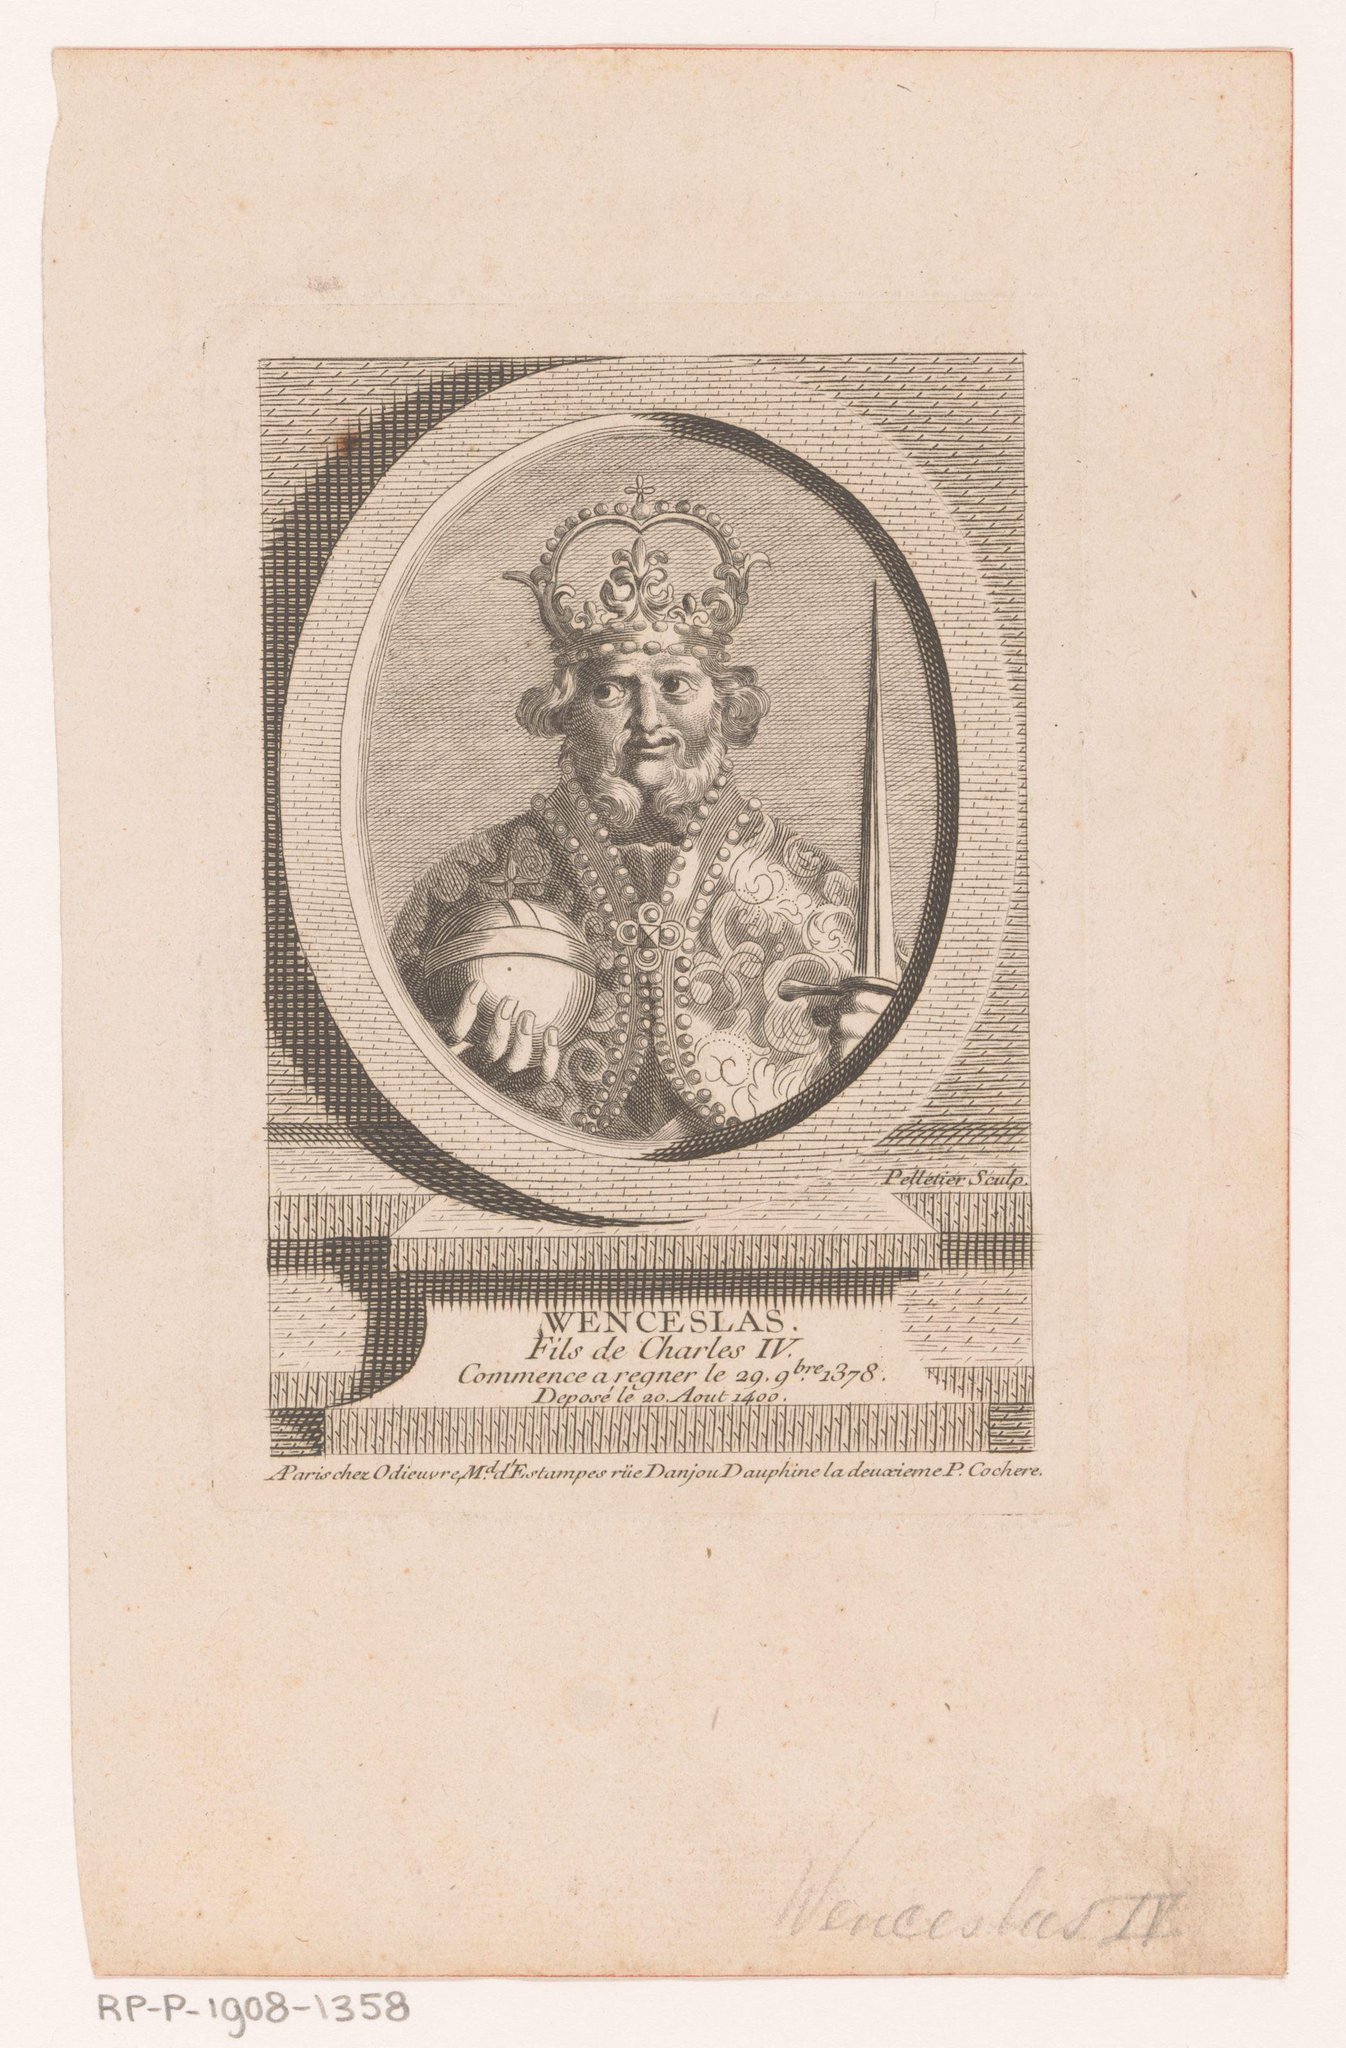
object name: book illustration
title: Wenceslas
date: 1755-1765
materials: paper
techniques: engraving, etching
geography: paris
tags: historical persons, king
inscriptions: collector's mark: Lugt 2228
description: Prent als illustratie gebruikt voor het boek: Dreux de Radier, Jean François. L'Europe illustre. Parijs: Michel Odieuvre, 1755-1765.